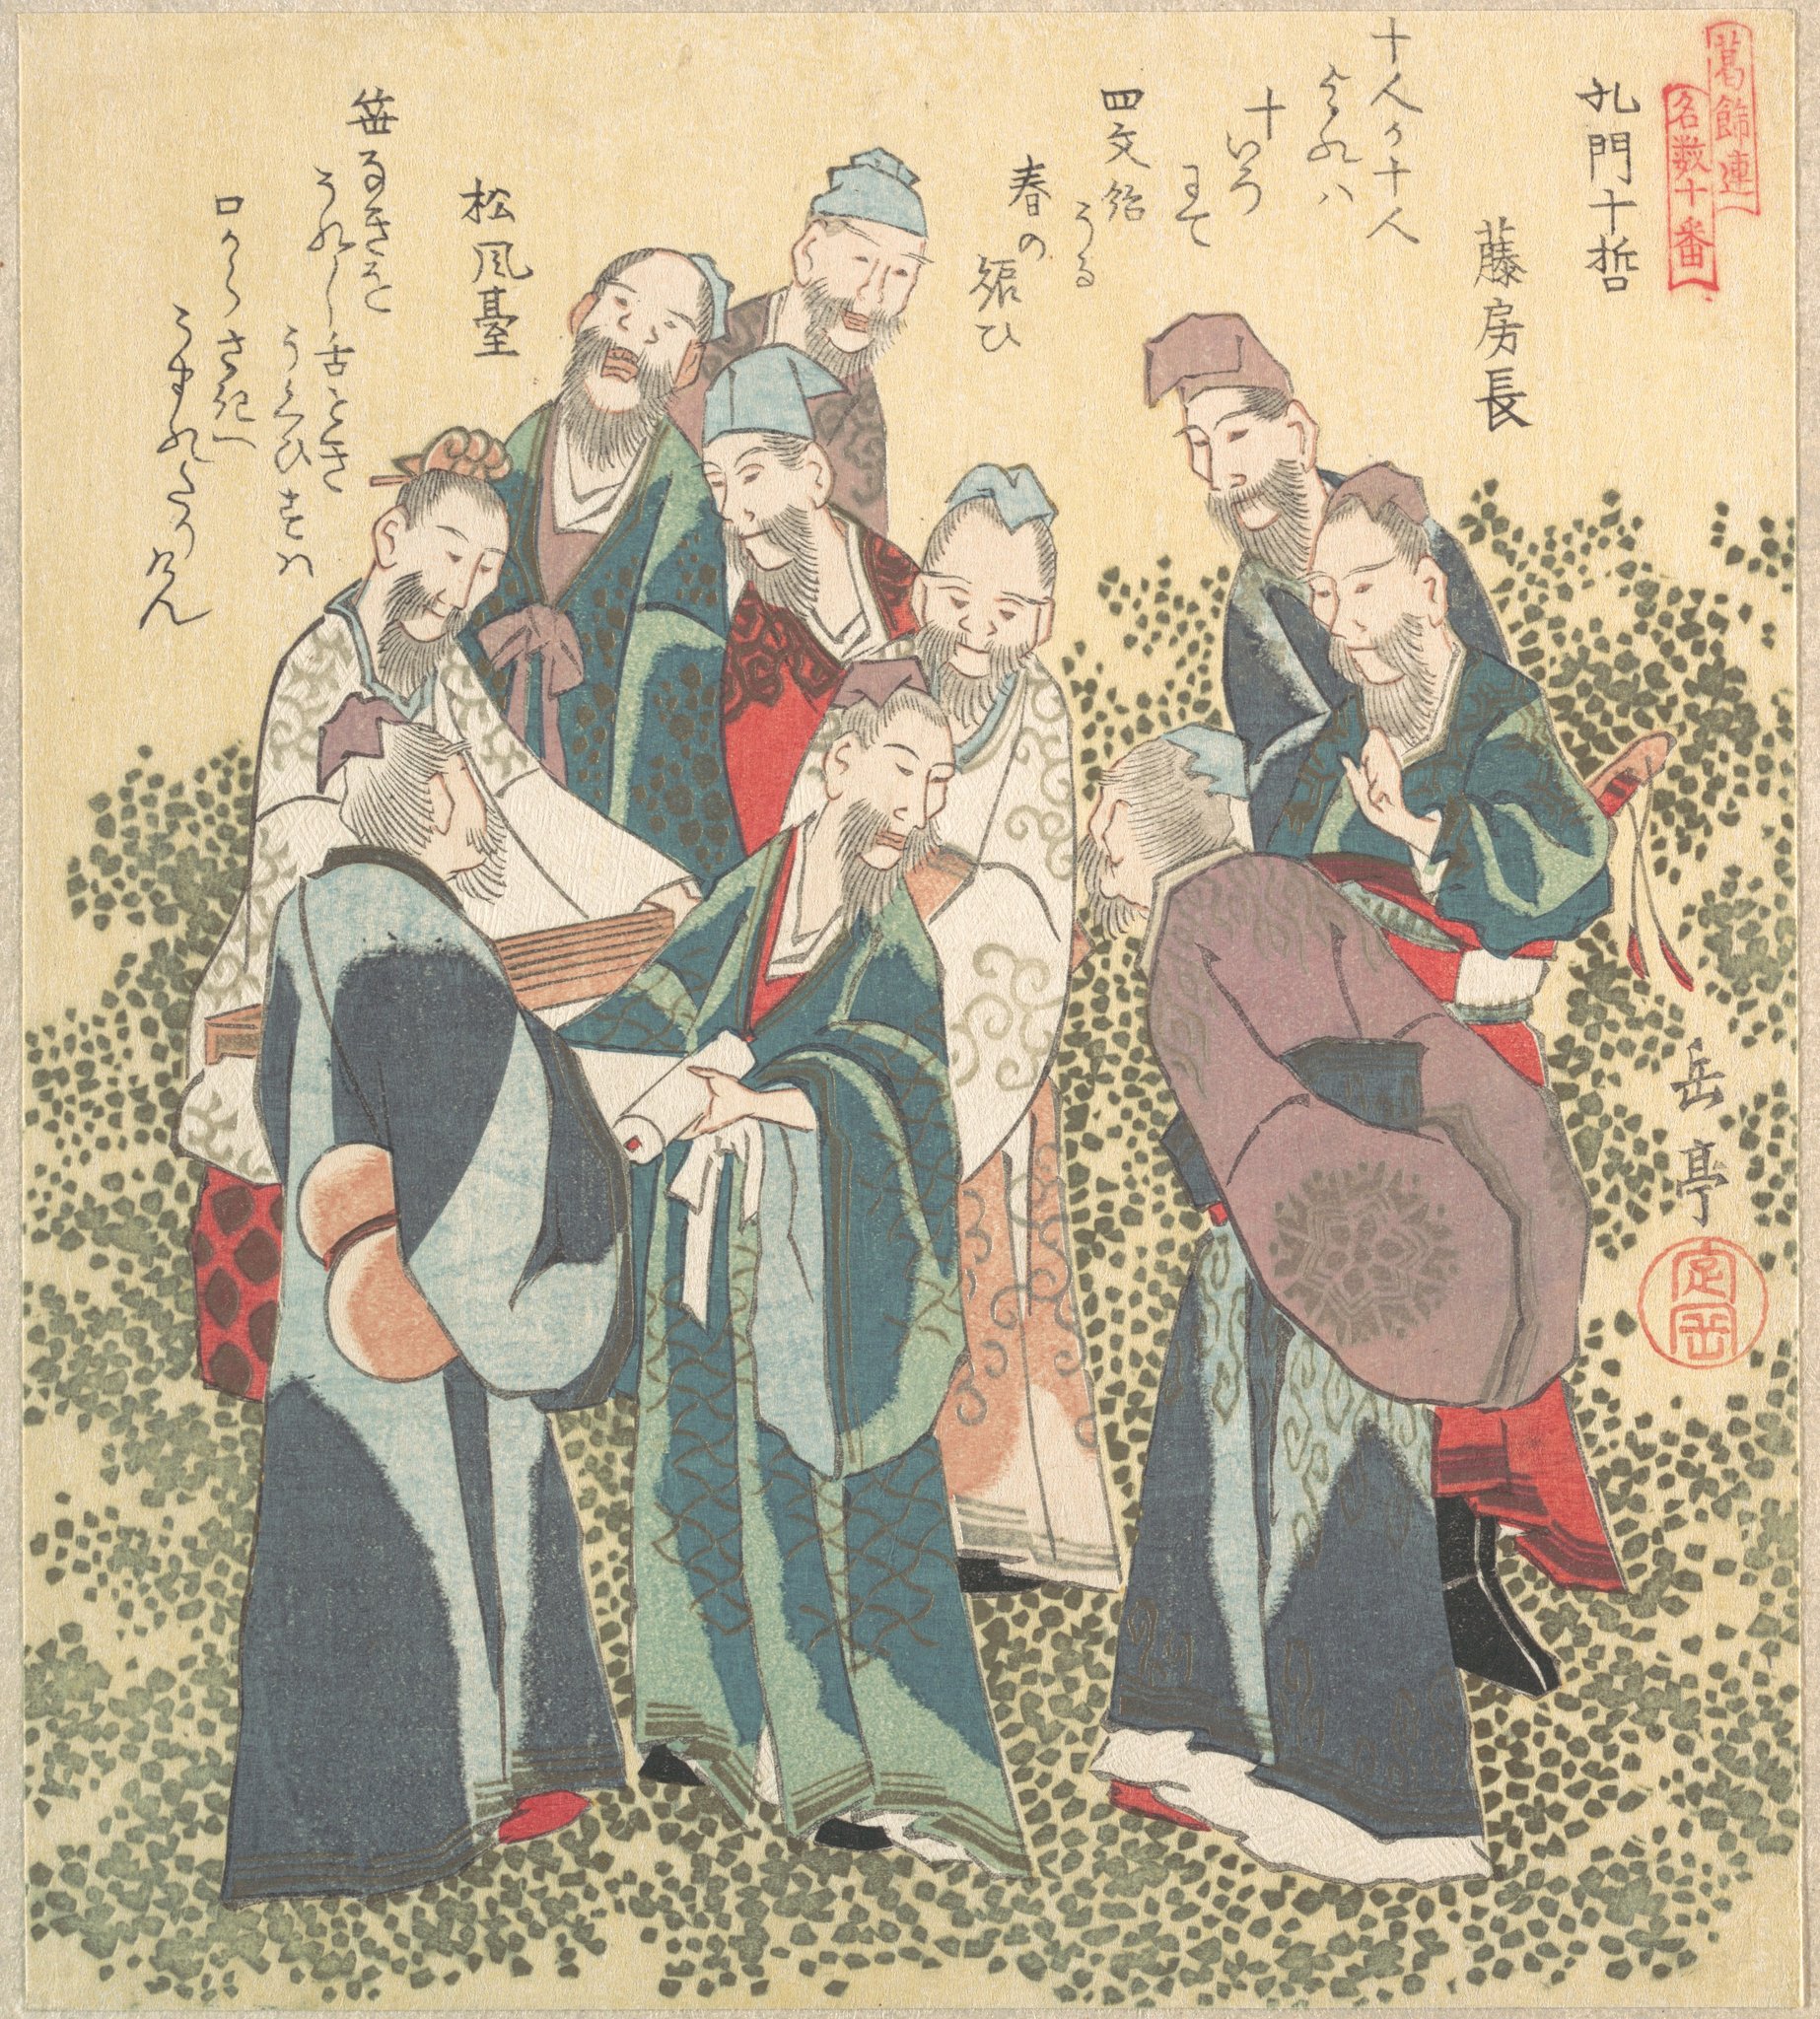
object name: print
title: Ten Wise Men Among the Disciples of Confucious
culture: japanese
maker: yashima gakutei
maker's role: artist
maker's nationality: japanese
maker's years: 1786-1868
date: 1801-1900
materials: ink, paper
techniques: surimono, woodblock print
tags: men